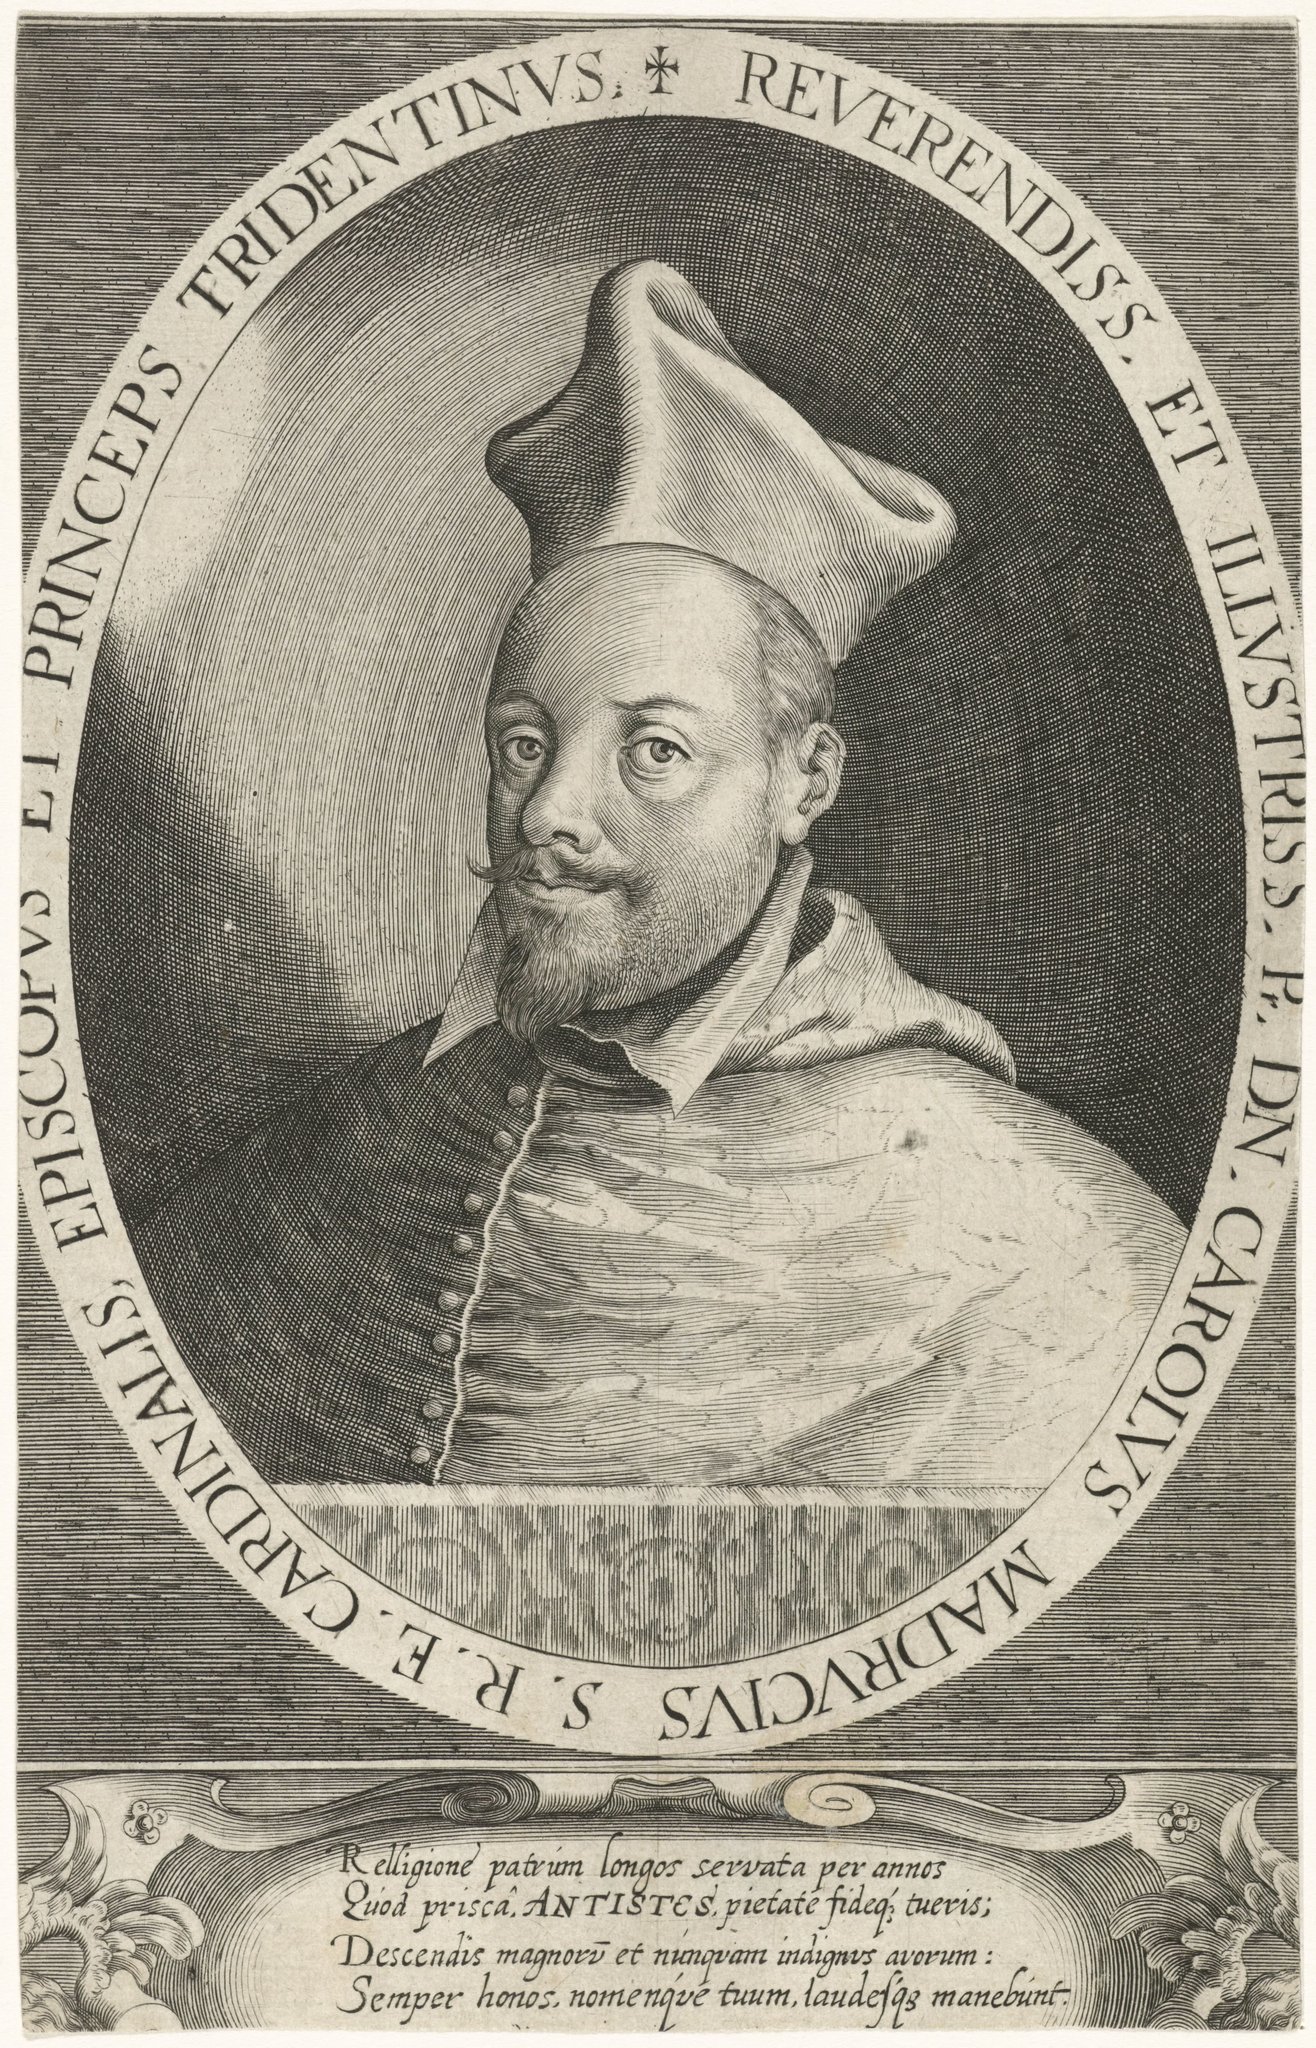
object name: print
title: Portret van bisschop Carlo Gaudenzio Madruzzo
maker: aegidius sadeler (ii)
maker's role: draughtsman, print maker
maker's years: 1568-1629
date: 1604-1629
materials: paper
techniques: engraving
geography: prague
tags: rome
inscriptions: collector's mark: Lugt 2228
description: Carlo Gaudenzio Madruzzo, kardinaal en bisschop van Trente. De prent heeft een Latijns onderschrift.